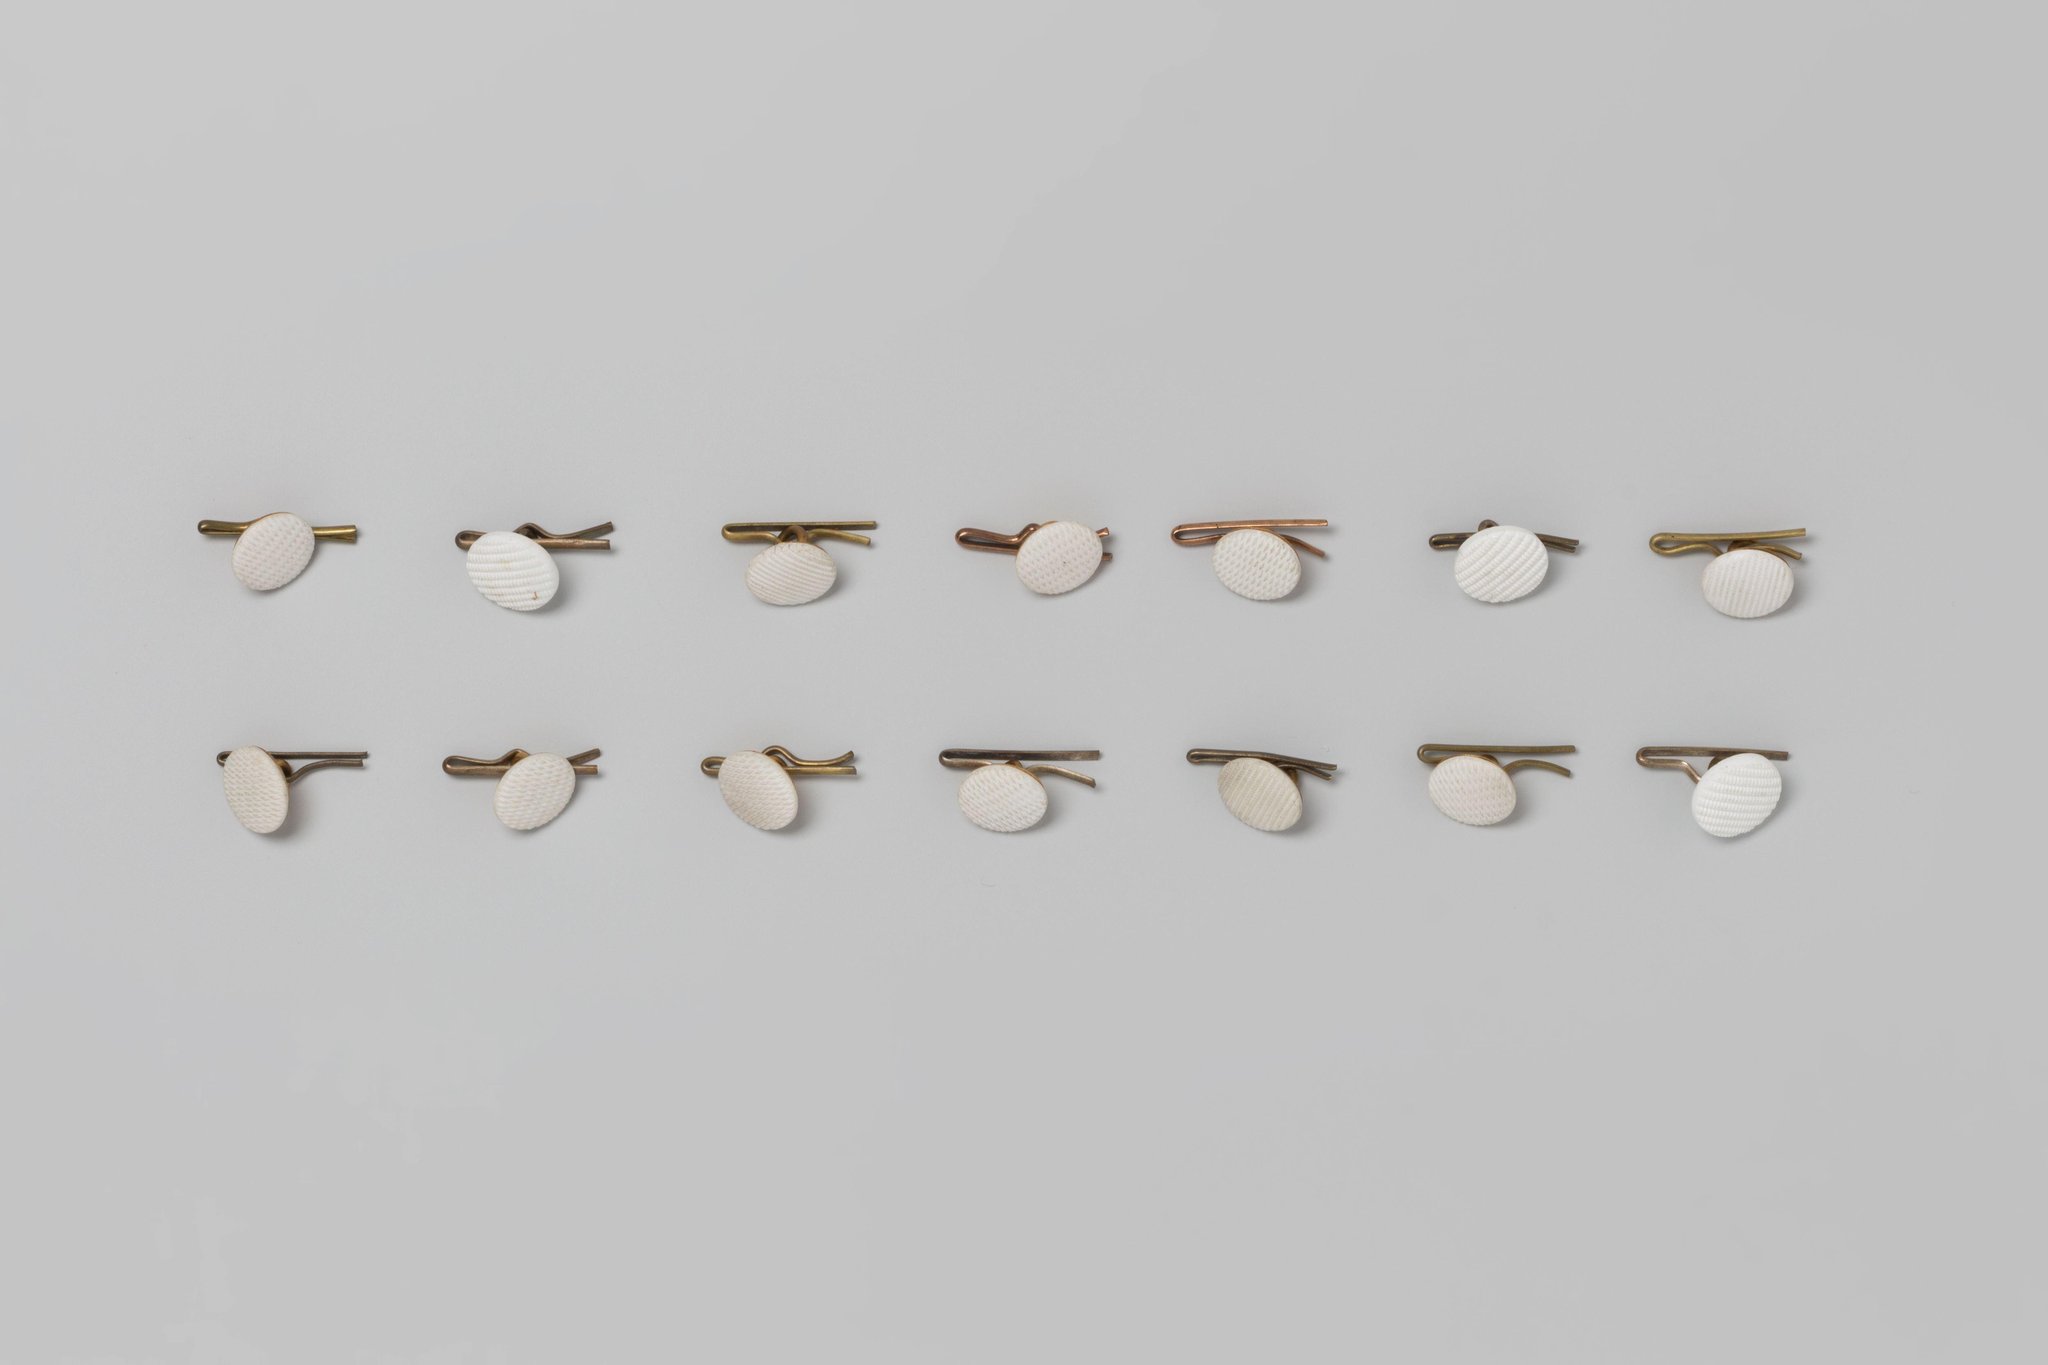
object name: vestknoop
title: Vestknoop van kunststof met reliëf-ribbel, vast oogje en losse tegenklem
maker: Anonymous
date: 1900-1940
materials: copper, plastic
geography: netherlands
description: Vestknoop van kunststof met reliëf-ribbel, vast oogje en losse tegenklem.